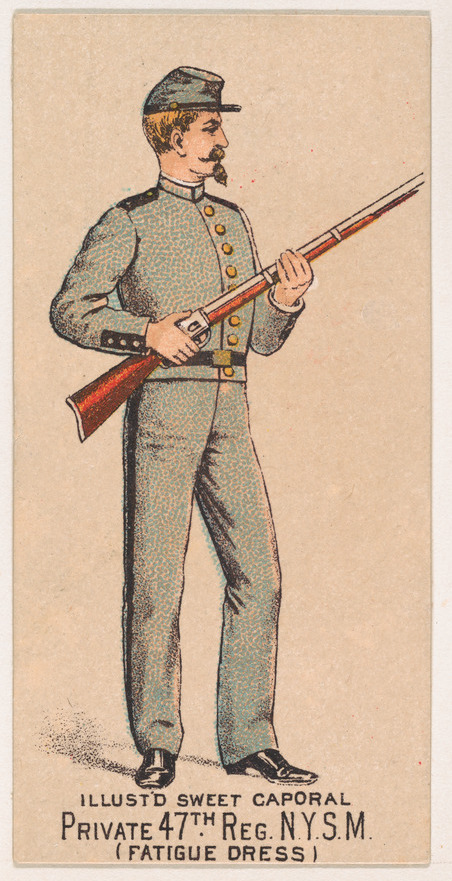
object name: print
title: Fatigue Dress, Private, 47th Regiment, New York State Militia, from the Military Series (N224) issued by Kinney Tobacco Company to promote Sweet Caporal Cigarettes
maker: kinney brothers tobacco company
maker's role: publisher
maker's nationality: american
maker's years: 1869-2011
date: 1888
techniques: color lithograph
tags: military,firearms,men,profiles